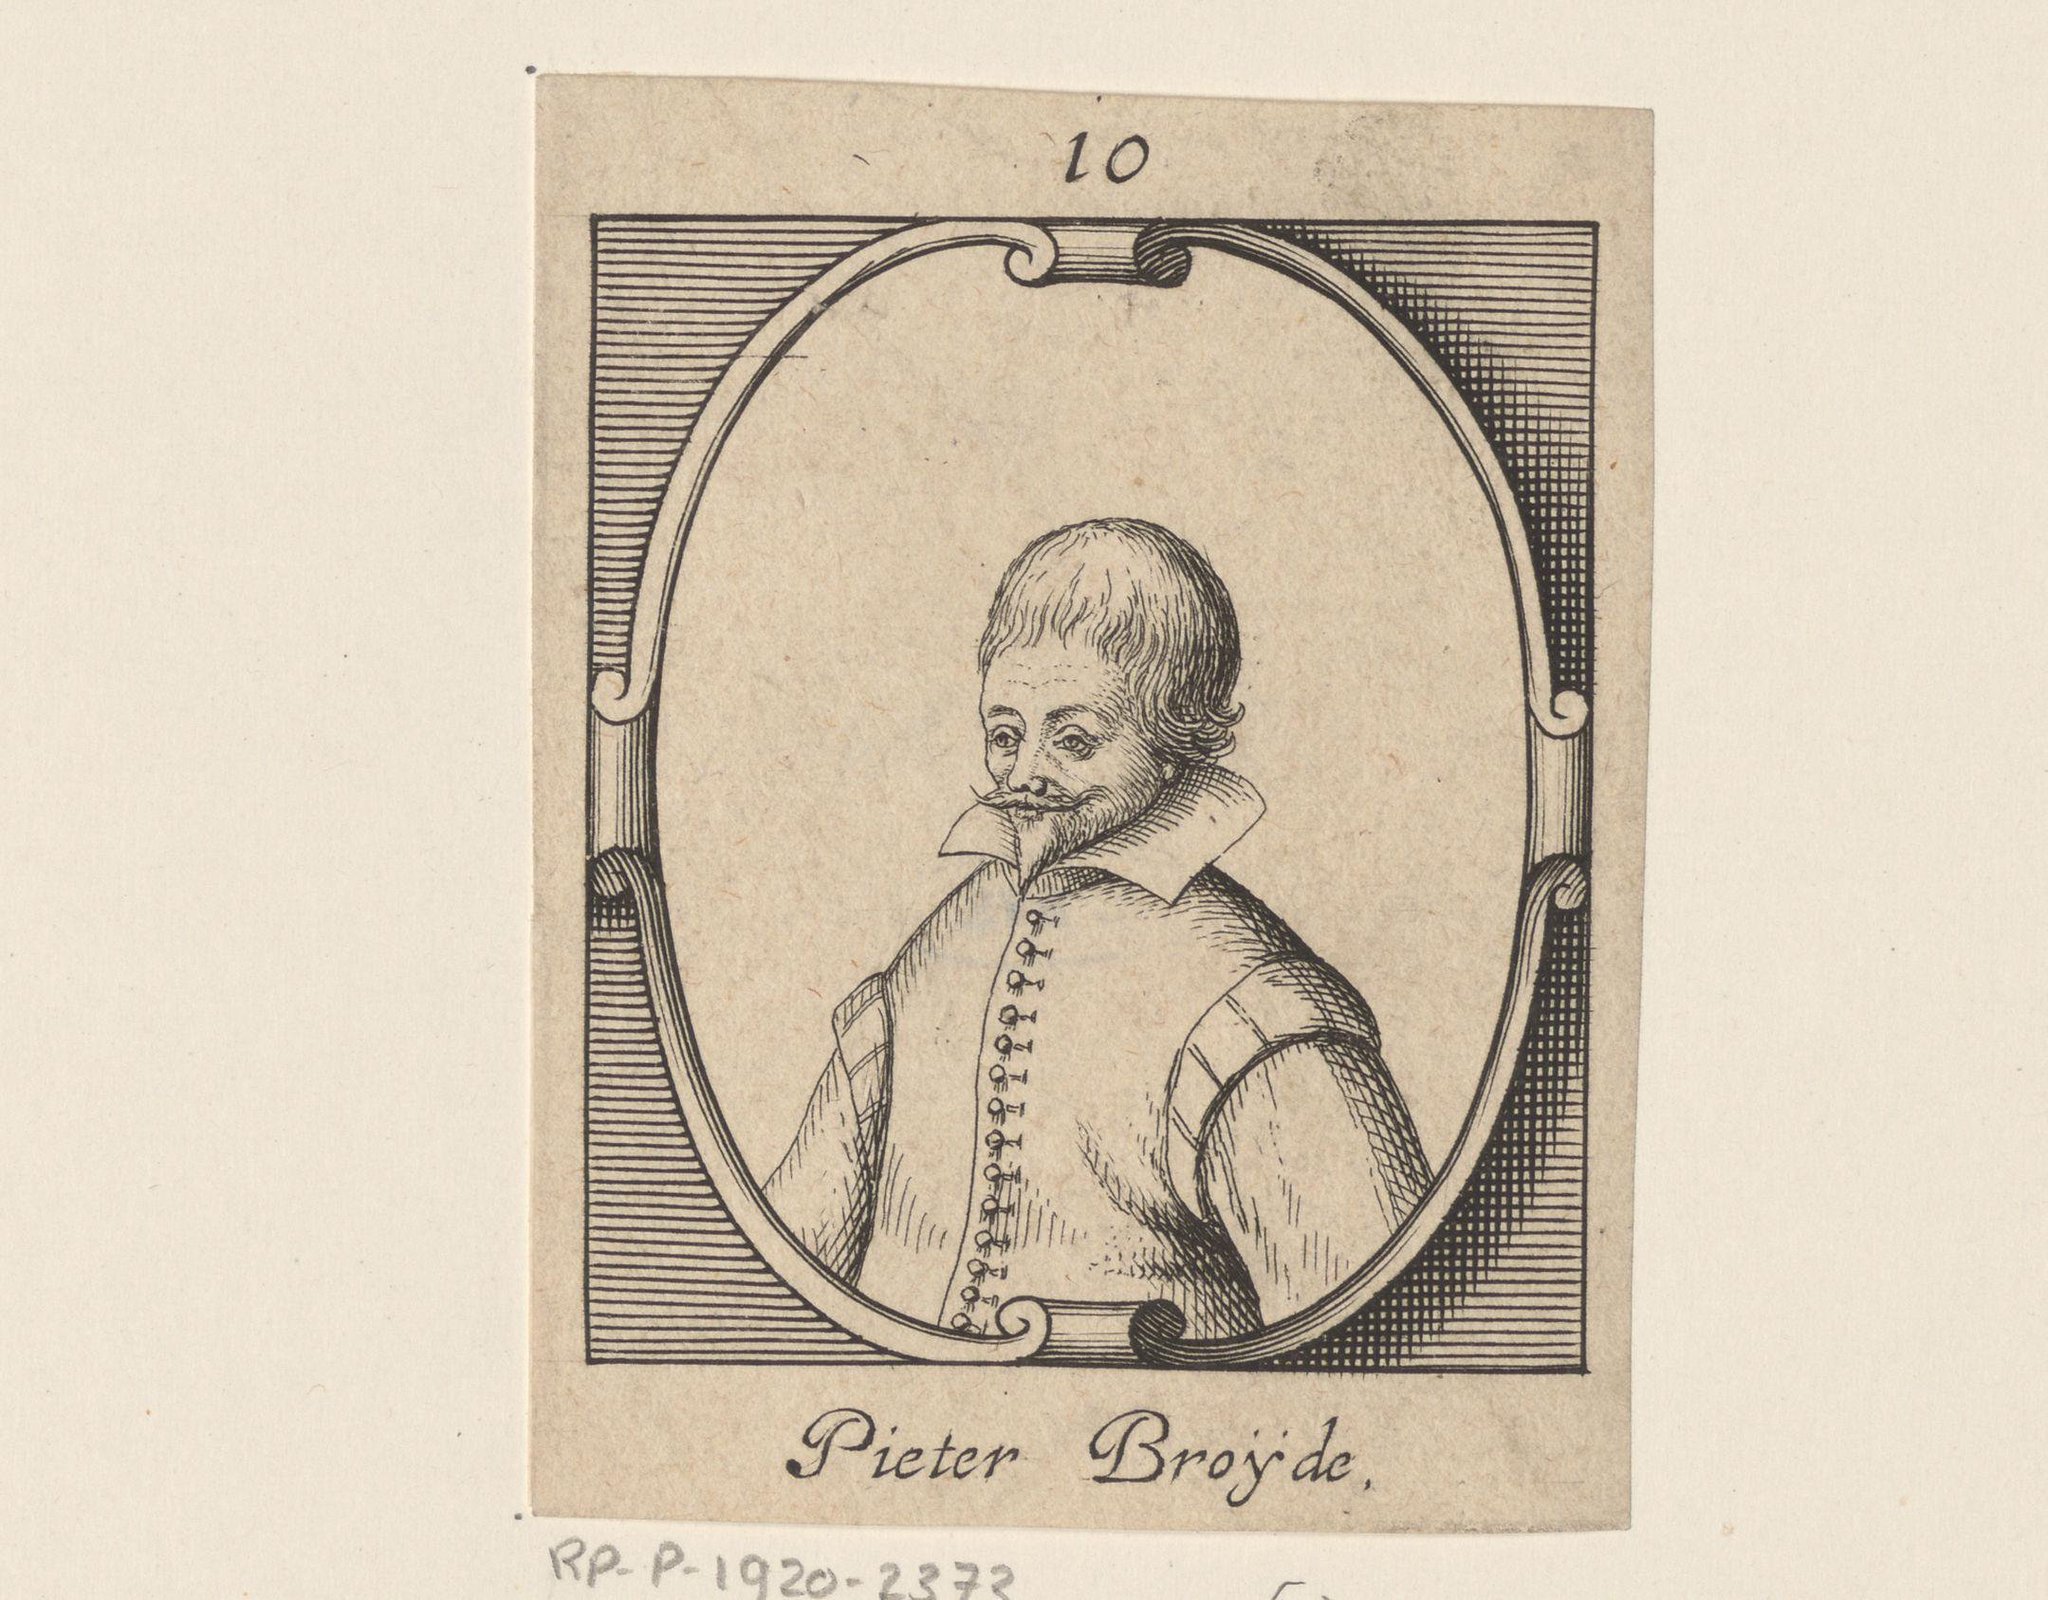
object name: print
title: Portret van Pieter Brode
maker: Anonymous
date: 1632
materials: paper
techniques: engraving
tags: historical persons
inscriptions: collector's mark: Lugt 2228